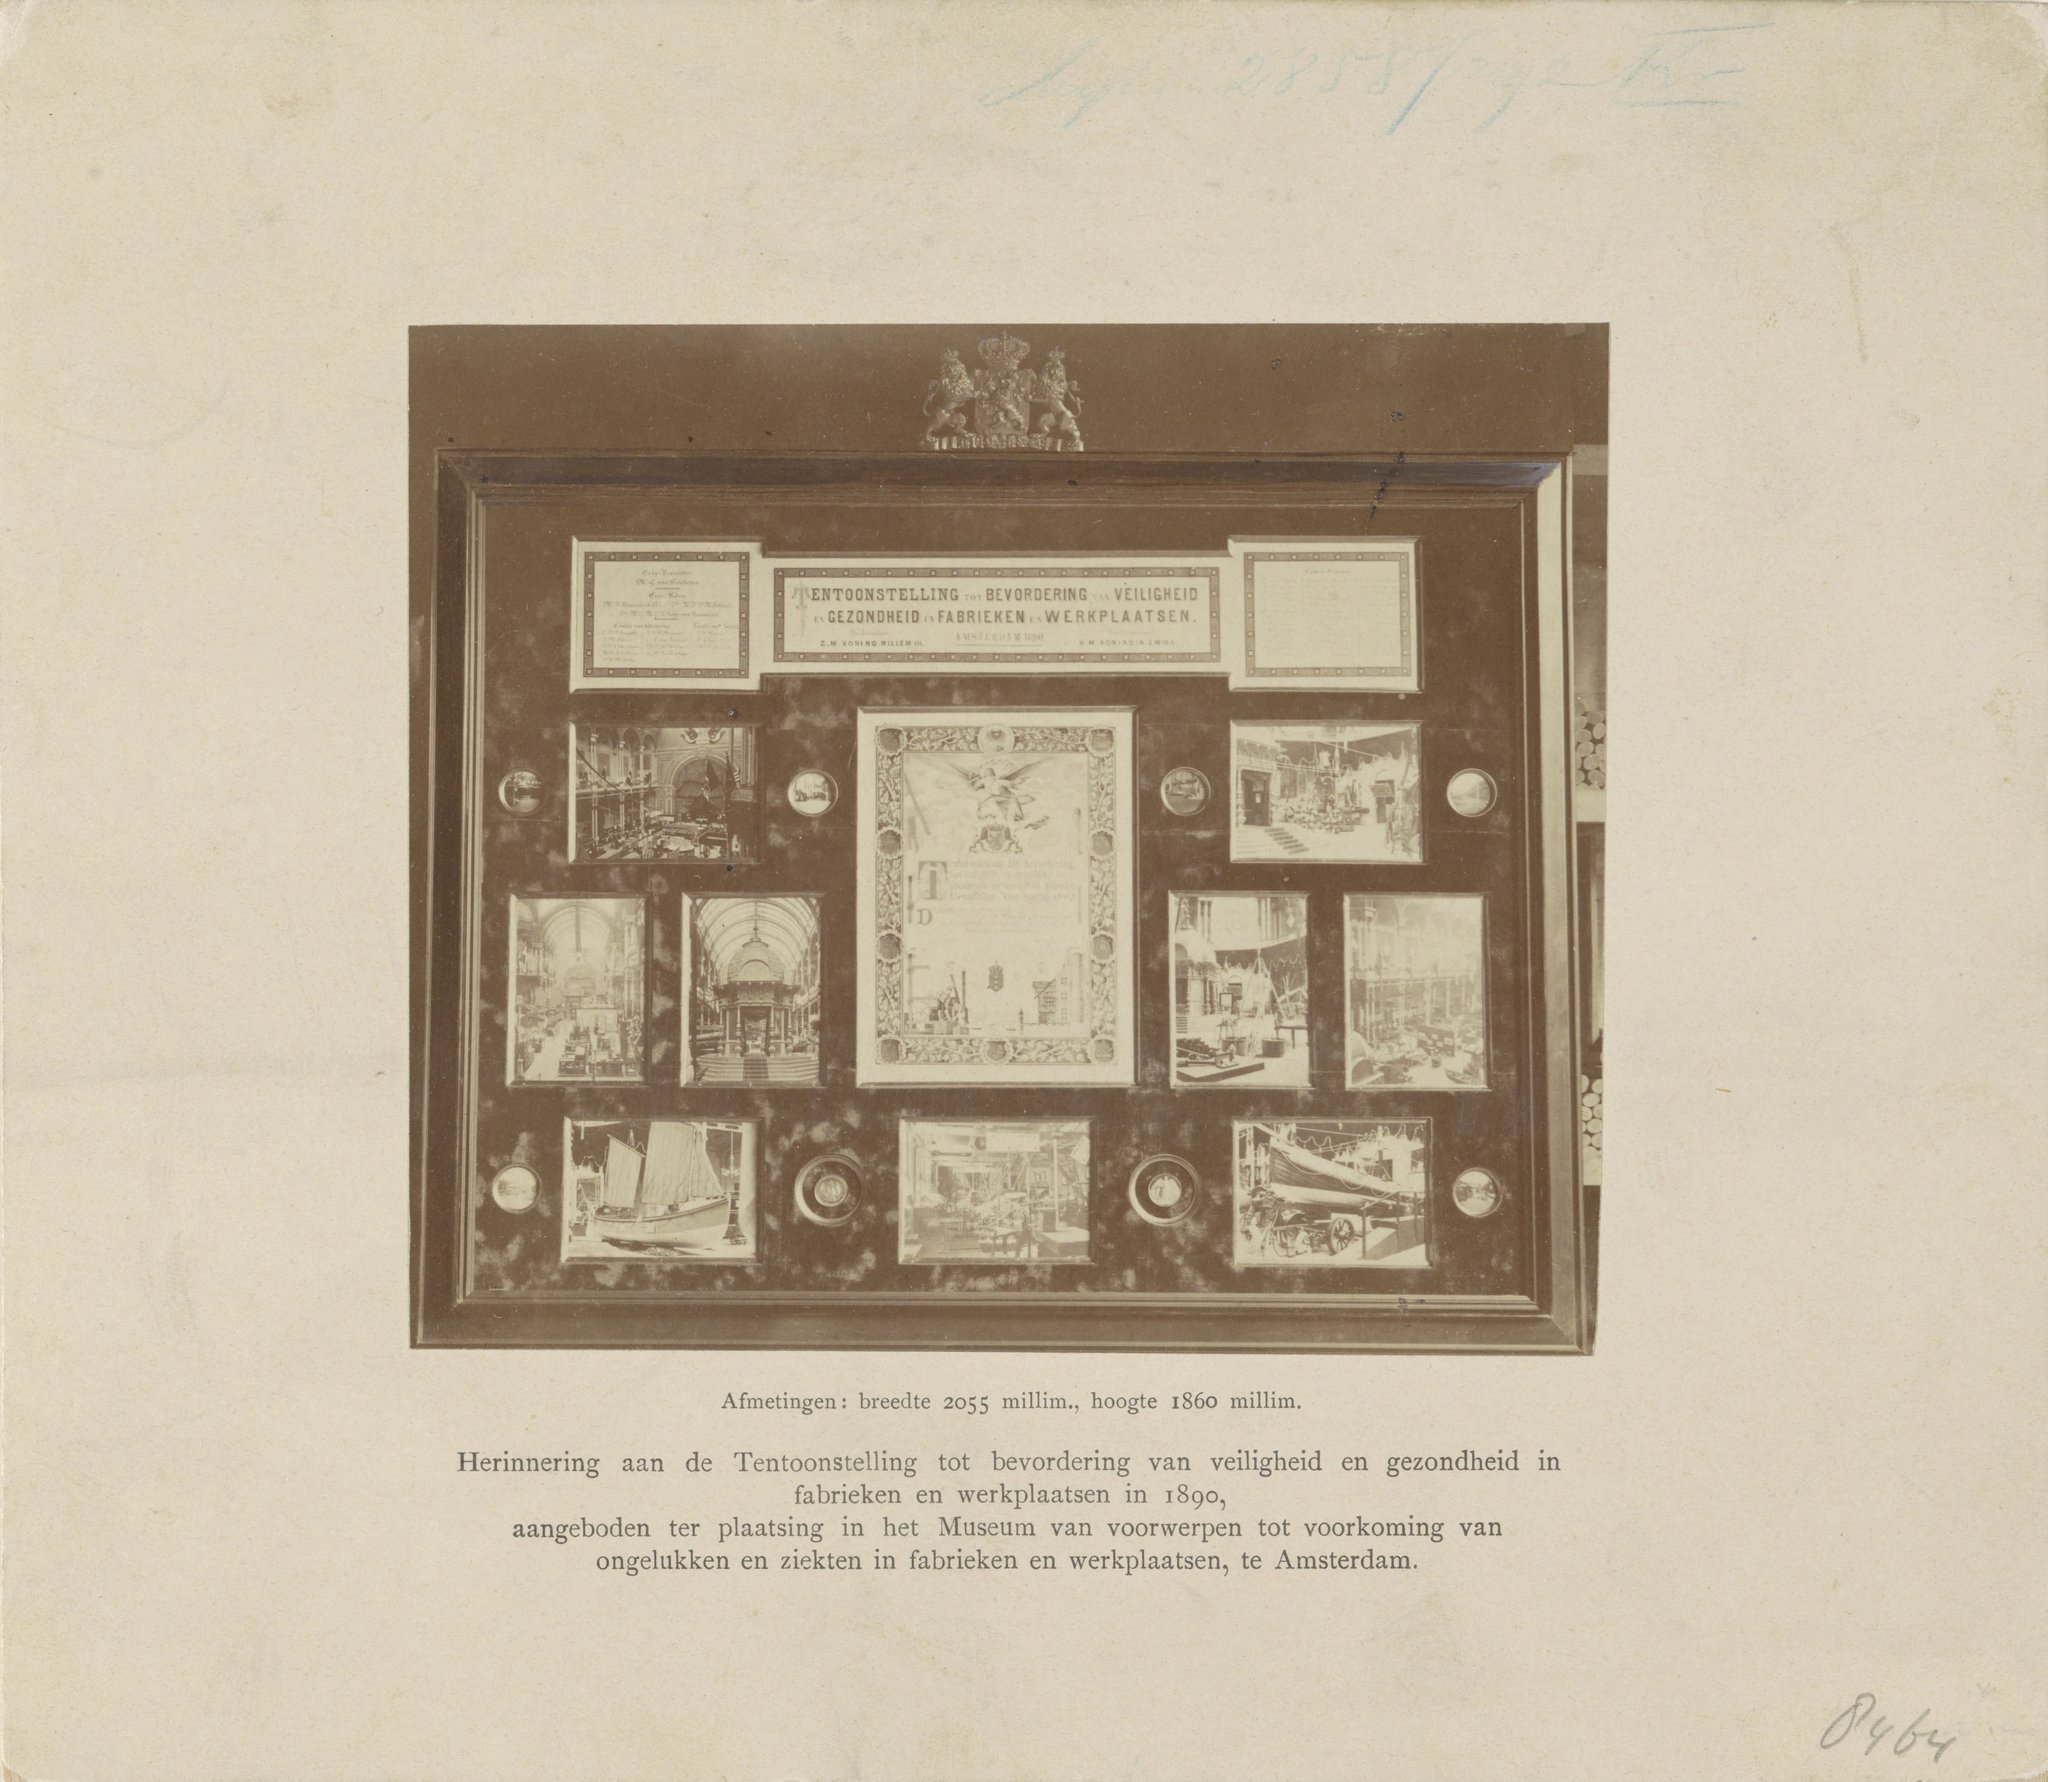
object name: photograph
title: Herinnering aan de Tentoonstelling tot bevordering van veiligheid en gezondheid in fabrieken en werkplaatsen in 1890, aangeboden ter plaatsing in het Museum van voorwerpen tot voorkoming van ongelukken en ziekten in fabrieken en werkplaatsen, te Amsterdam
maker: Anonymous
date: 1890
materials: cardboard, paper, photographic support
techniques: albumen print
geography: netherlands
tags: photograph, handicrafts and industries, amsterdam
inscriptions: collector's mark: Lugt 2228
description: Herinneringsplaat van de Tentoonstelling tot bevordering van veiligheid en gezondheid in fabrieken en werkplaatsen, Amsterdam 1890. Ingelijste foto's en diploma's.